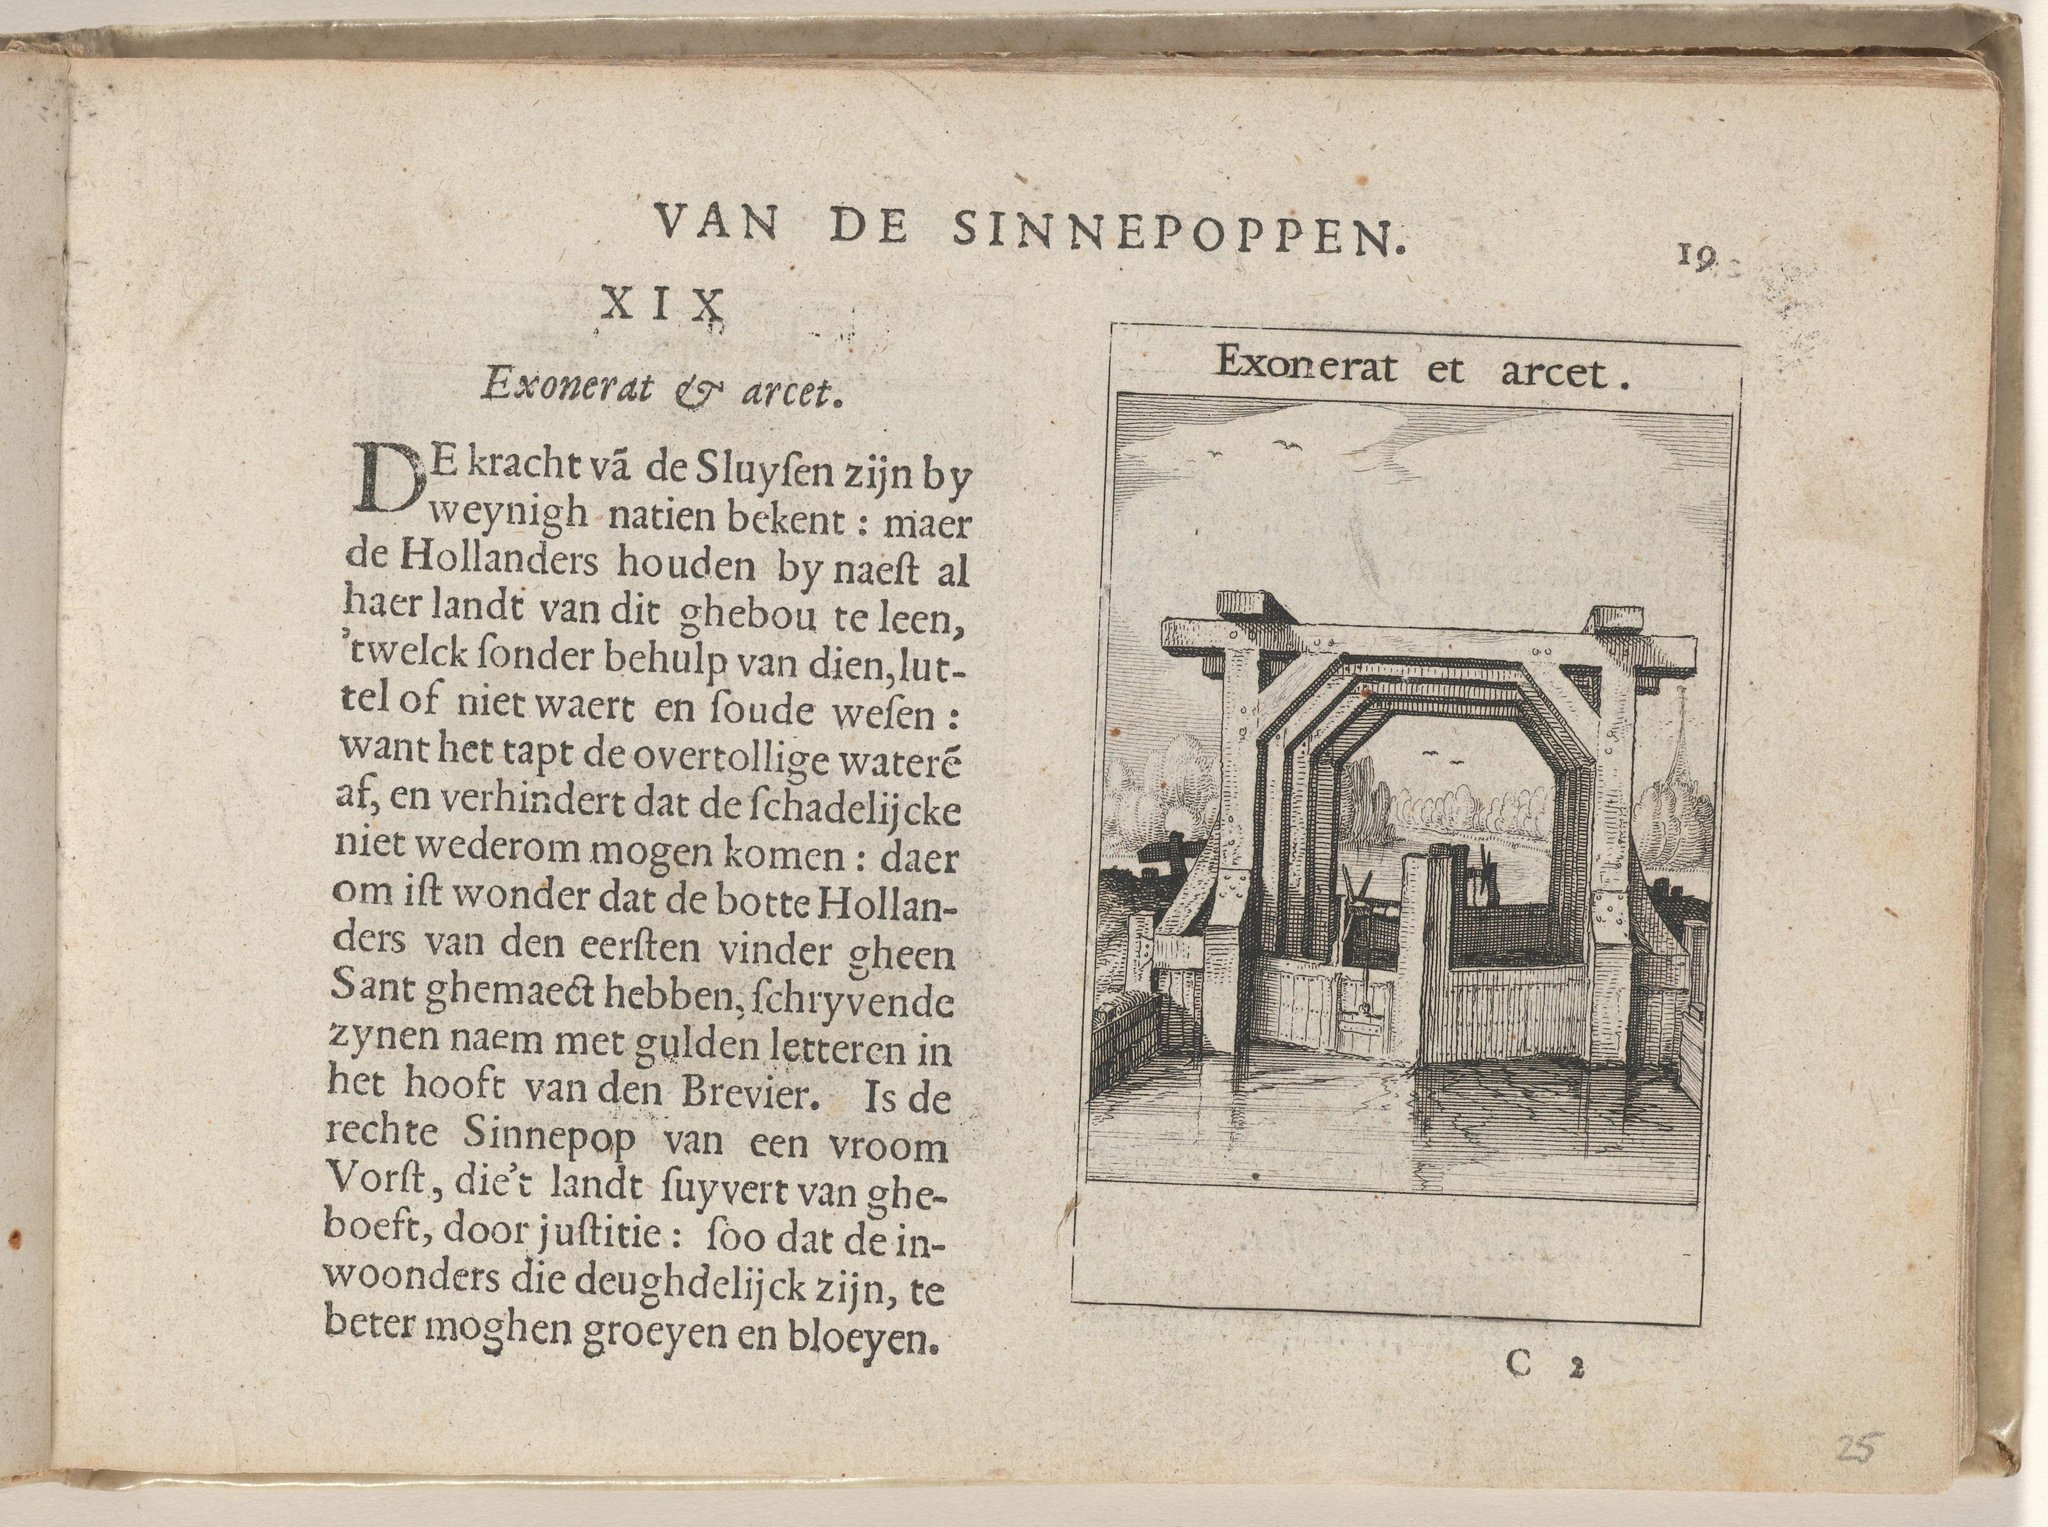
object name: print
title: XIX Exonerat et arcet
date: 1614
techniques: engraving, printing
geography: the hague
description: XIX Exonerat et arcet. Eerste schok. Onderdeel van 'Sinnepoppen', R. Visscher, 1614.